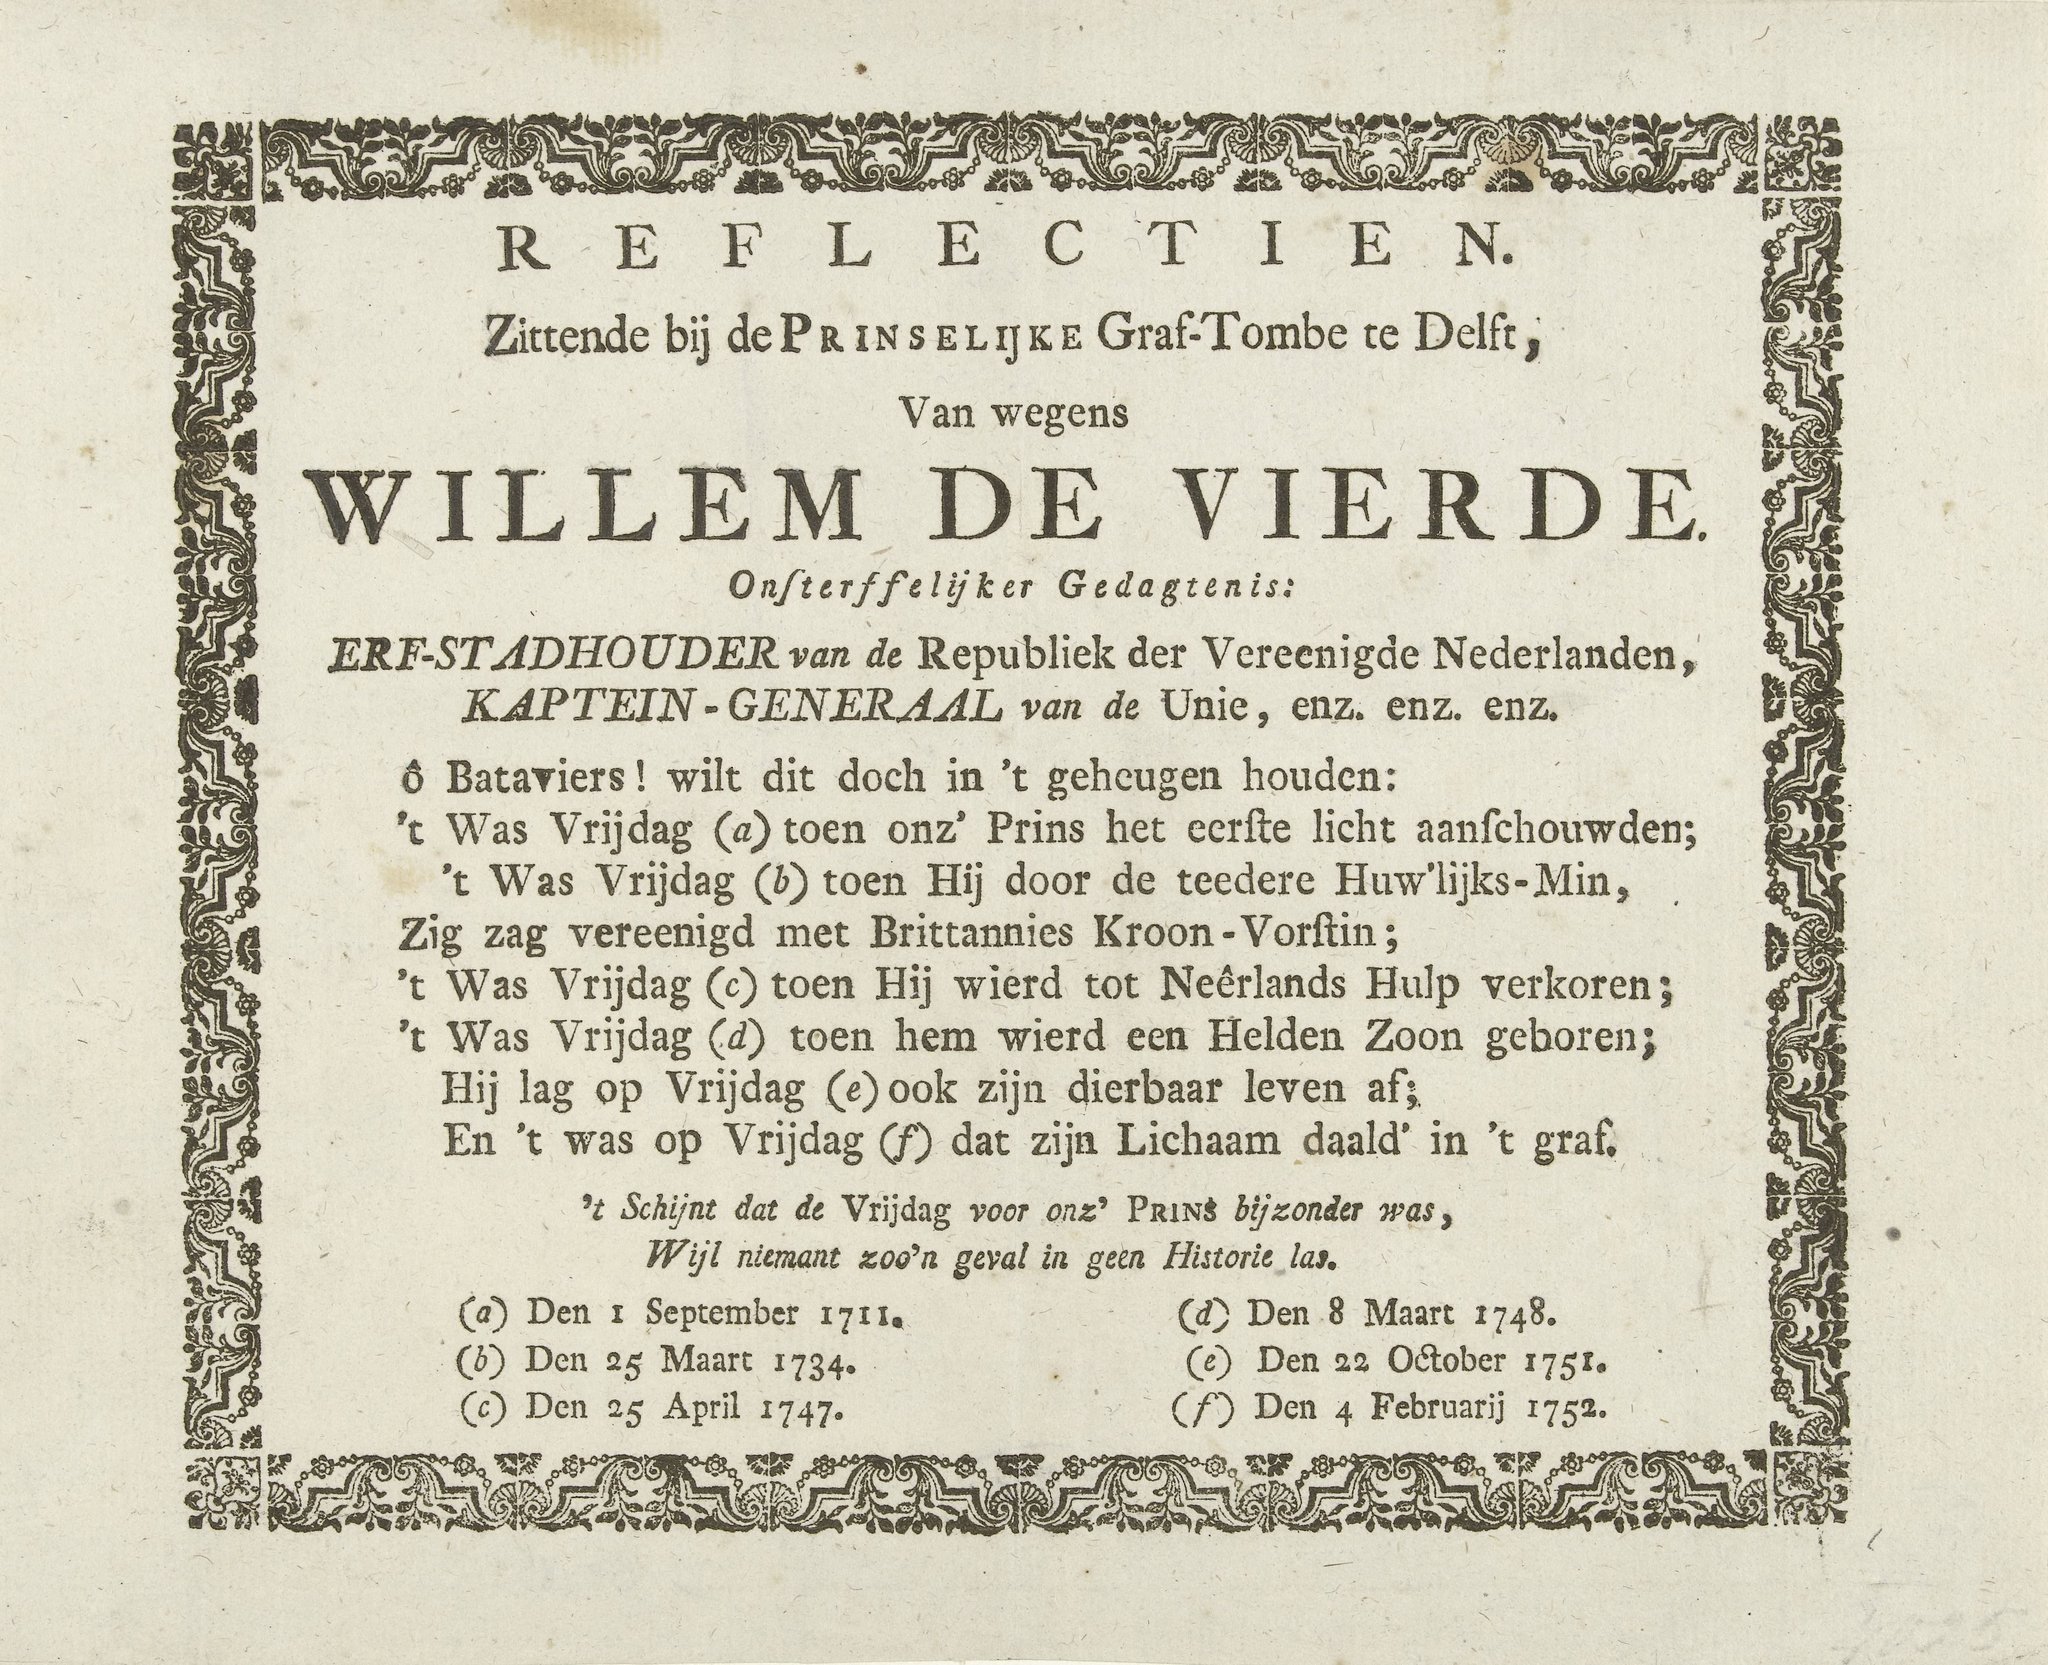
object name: text sheet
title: Reflectien. Zittende bij de Prinselijke Graf-Tombe te Delft, Van wegens Willem de Vierde (...)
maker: Anonymous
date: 1752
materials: paper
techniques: letterpress printing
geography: northern netherlands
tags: the hague, willem iv (prins van oranje-nassau)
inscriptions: collector's mark: Lugt 2228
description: Tekstblad met een vers op de zes gebeurtenissen uit het leven van prins Willem IV die alle in de jaren 1711-1752 op een vrijdag plaatsvonden. Tekst in decoratieve lijst.